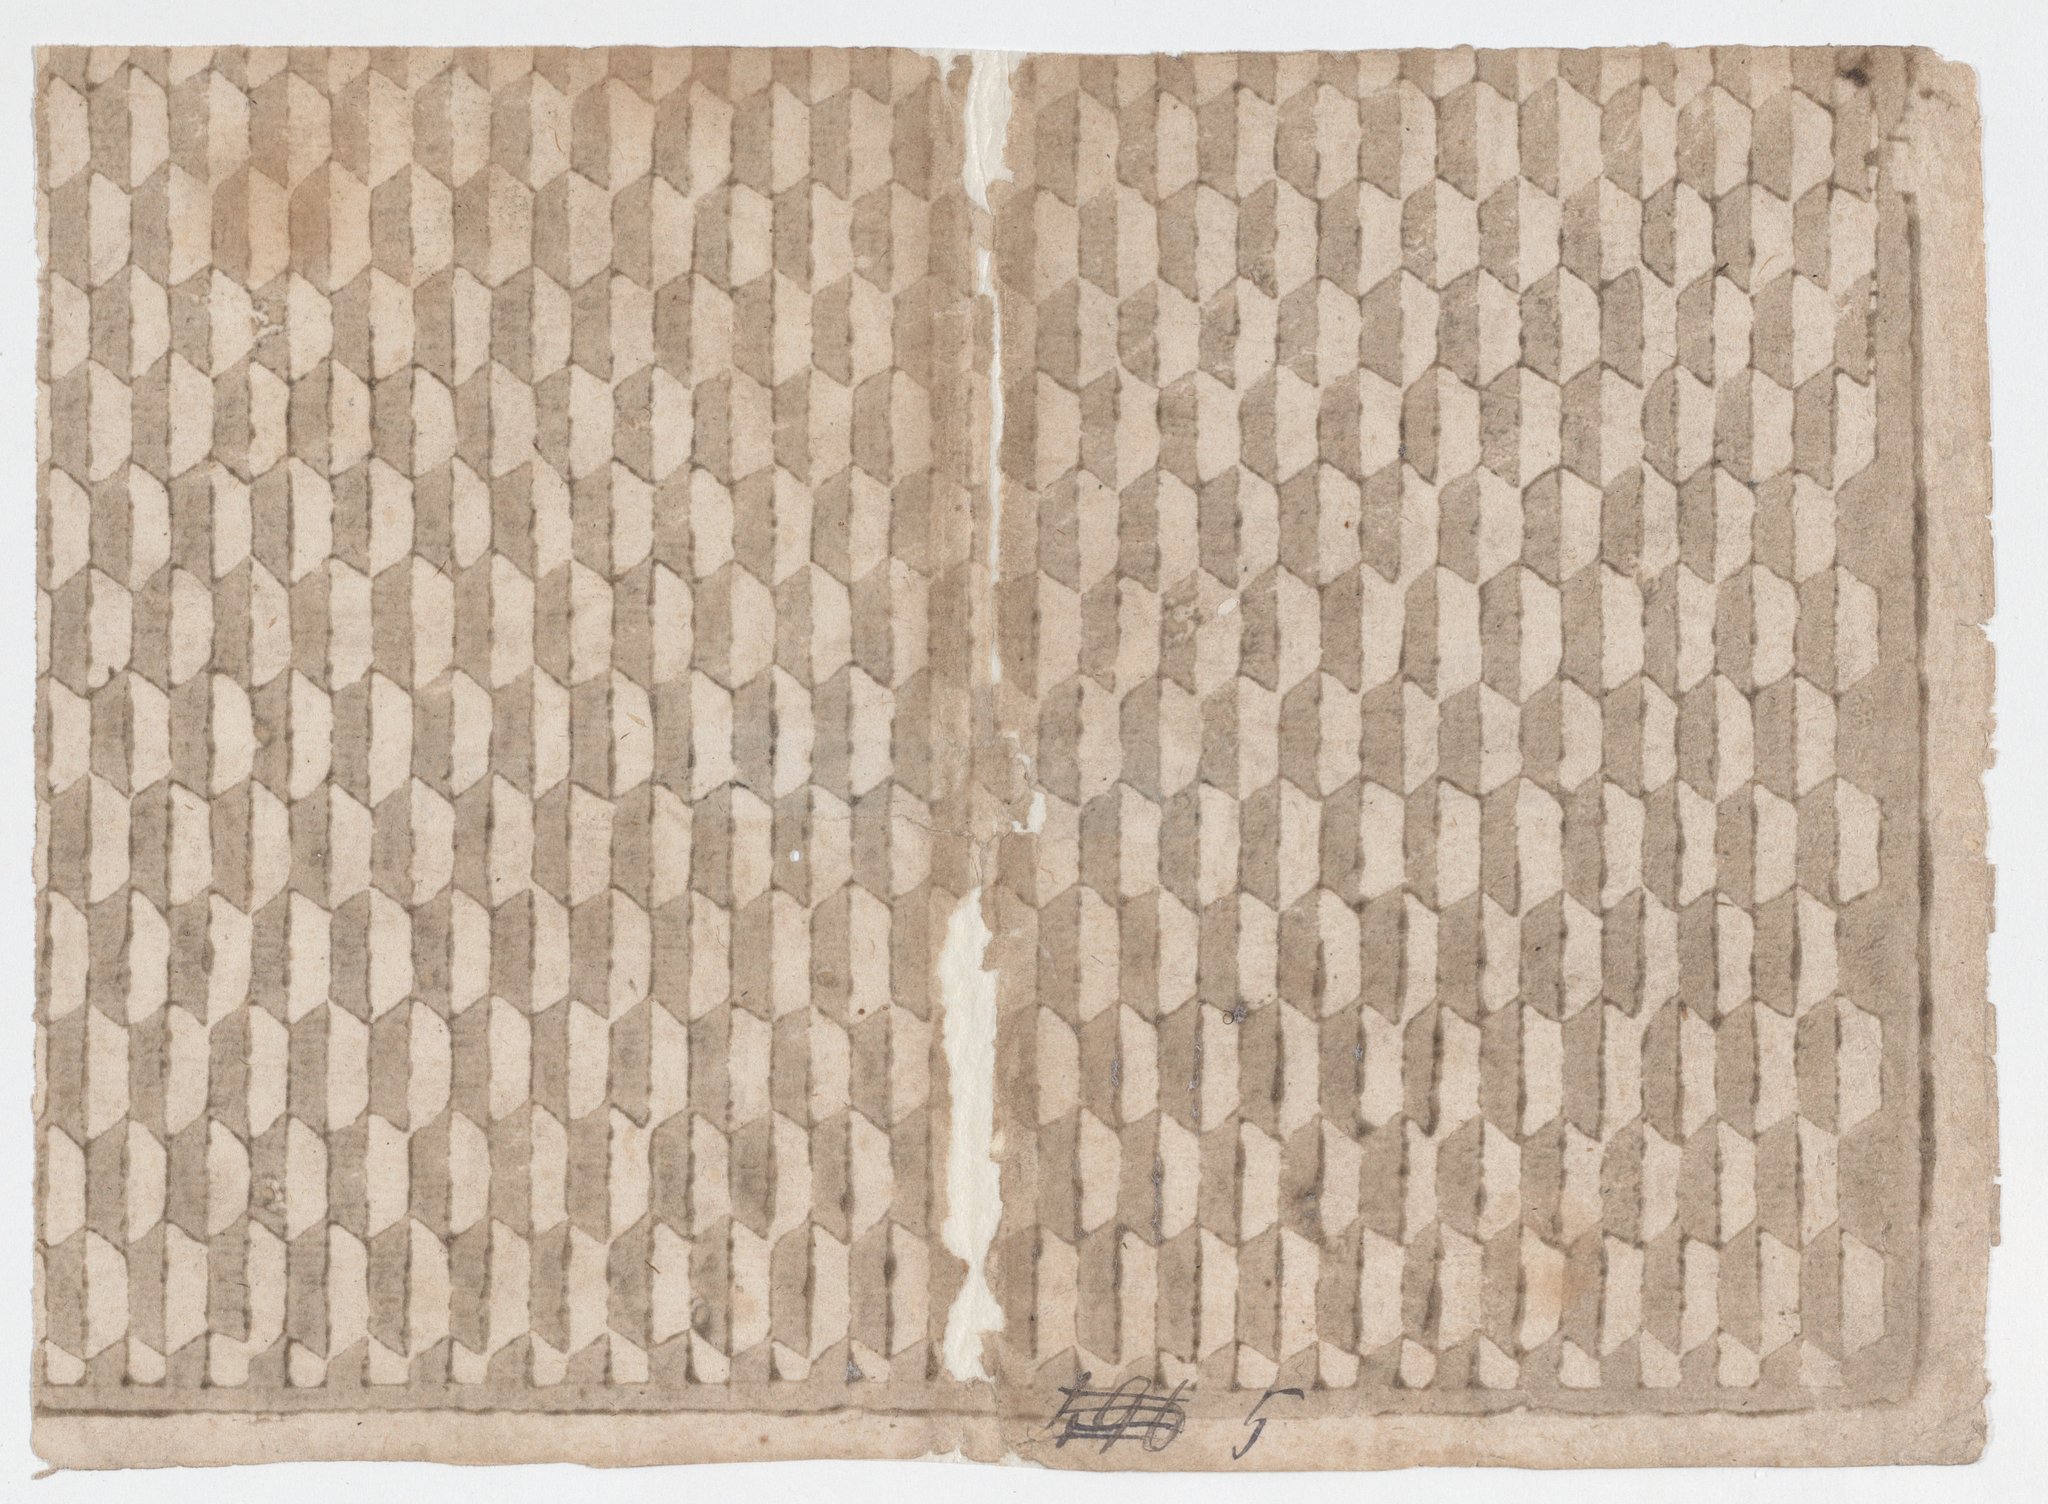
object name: print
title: Sheet with overall abstract pattern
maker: Anonymous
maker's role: artist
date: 1801-1900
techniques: relief print